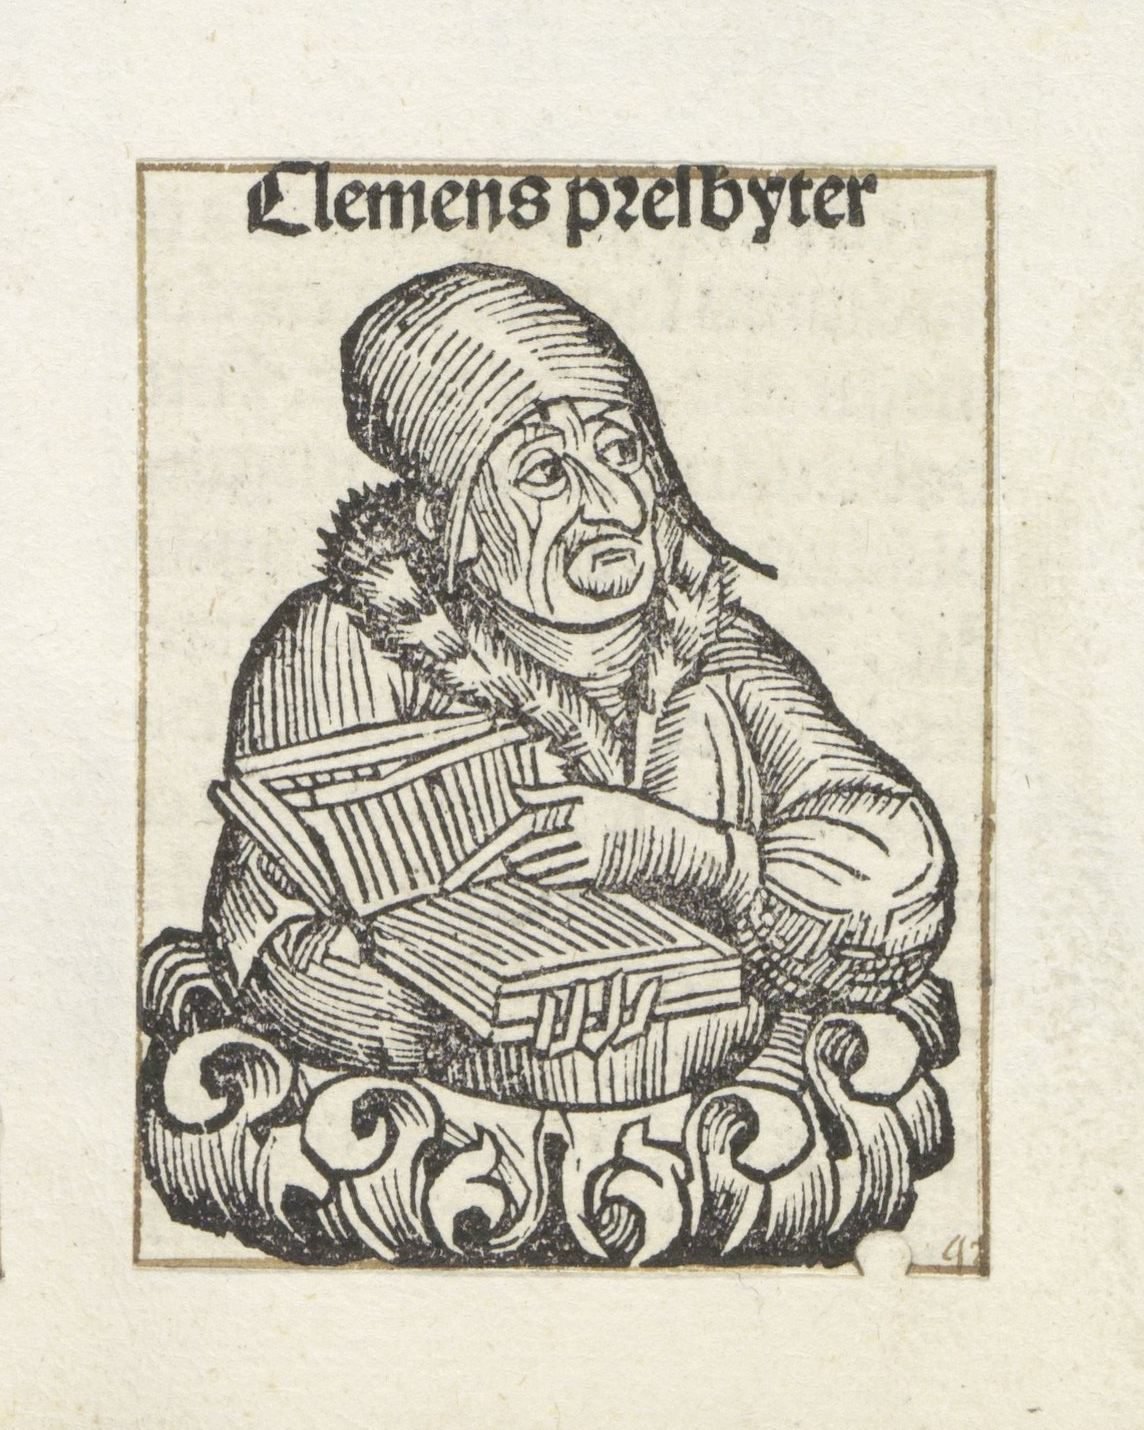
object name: album leaf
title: Liber Chronicarum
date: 1493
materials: paper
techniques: letterpress printing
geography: nuremberg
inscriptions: inscription: ‘42’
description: De houtsnede wordt herhaaldelijk gebruikt als boekillustratie in de Liber Chronicarum (of Neurenbergkroniek) van Hartmann Schedel, verschenen in het Latijn en Duits in 1493. Zie de Latijnse uitgave, folio 115v.